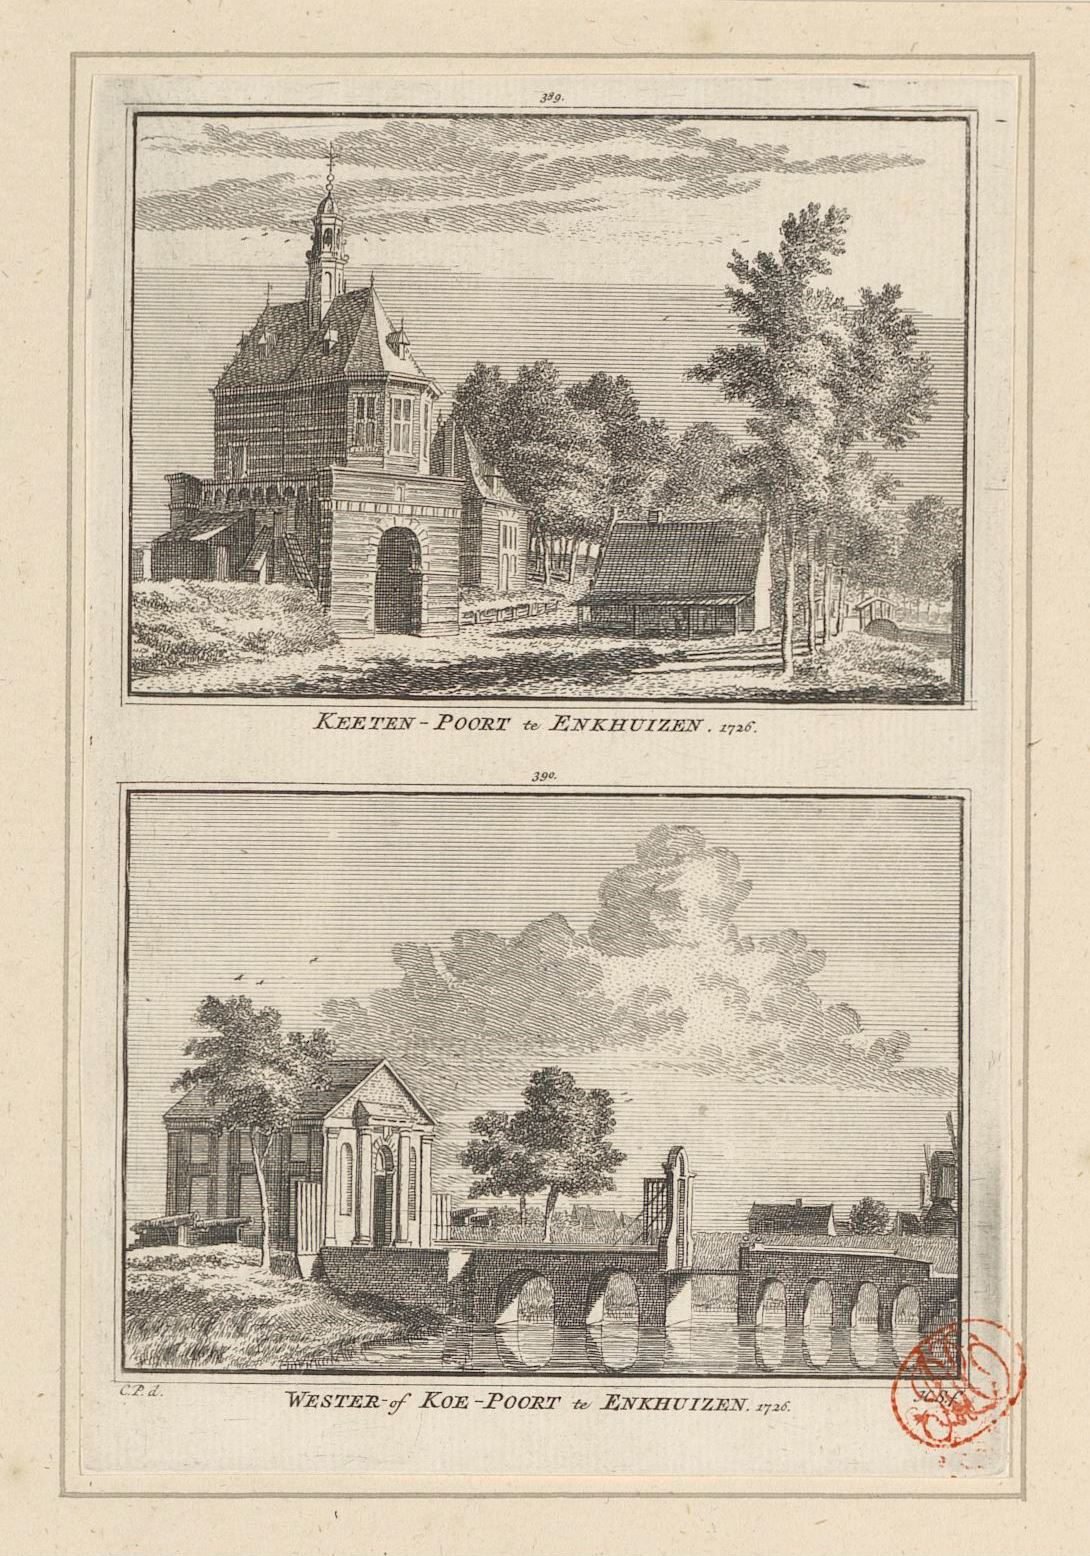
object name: print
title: Keeten-poort te Enkhuizen. 1726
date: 1752-1792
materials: paper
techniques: engraving, etching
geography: haarlem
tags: bridge, city-gate, enkhuizen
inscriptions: collector's mark: Lugt 195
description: Prent ook gebruikt in: Het verheerlykt Nederland of kabinet van hedendaagsche gezigten van steden, dorpen (…). 9 delen. Amsterdam: Isaak Tirion en weduwe Isaak Tirion, 1745-1774, dl. 4 (1752), ill. 389 en 390. Of in: Nederlandsche tafereelen; of eene keurige verzameling van negen honderd fraaije gezigten van steden, dorpen, sloten, oudheden (….). 9 delen. Amsterdam: Jan de Groot, 1792, dl. 4, ill. 389 en 390. Uit welke druk het huidige exemplaar precies komt is niet na te gaan.